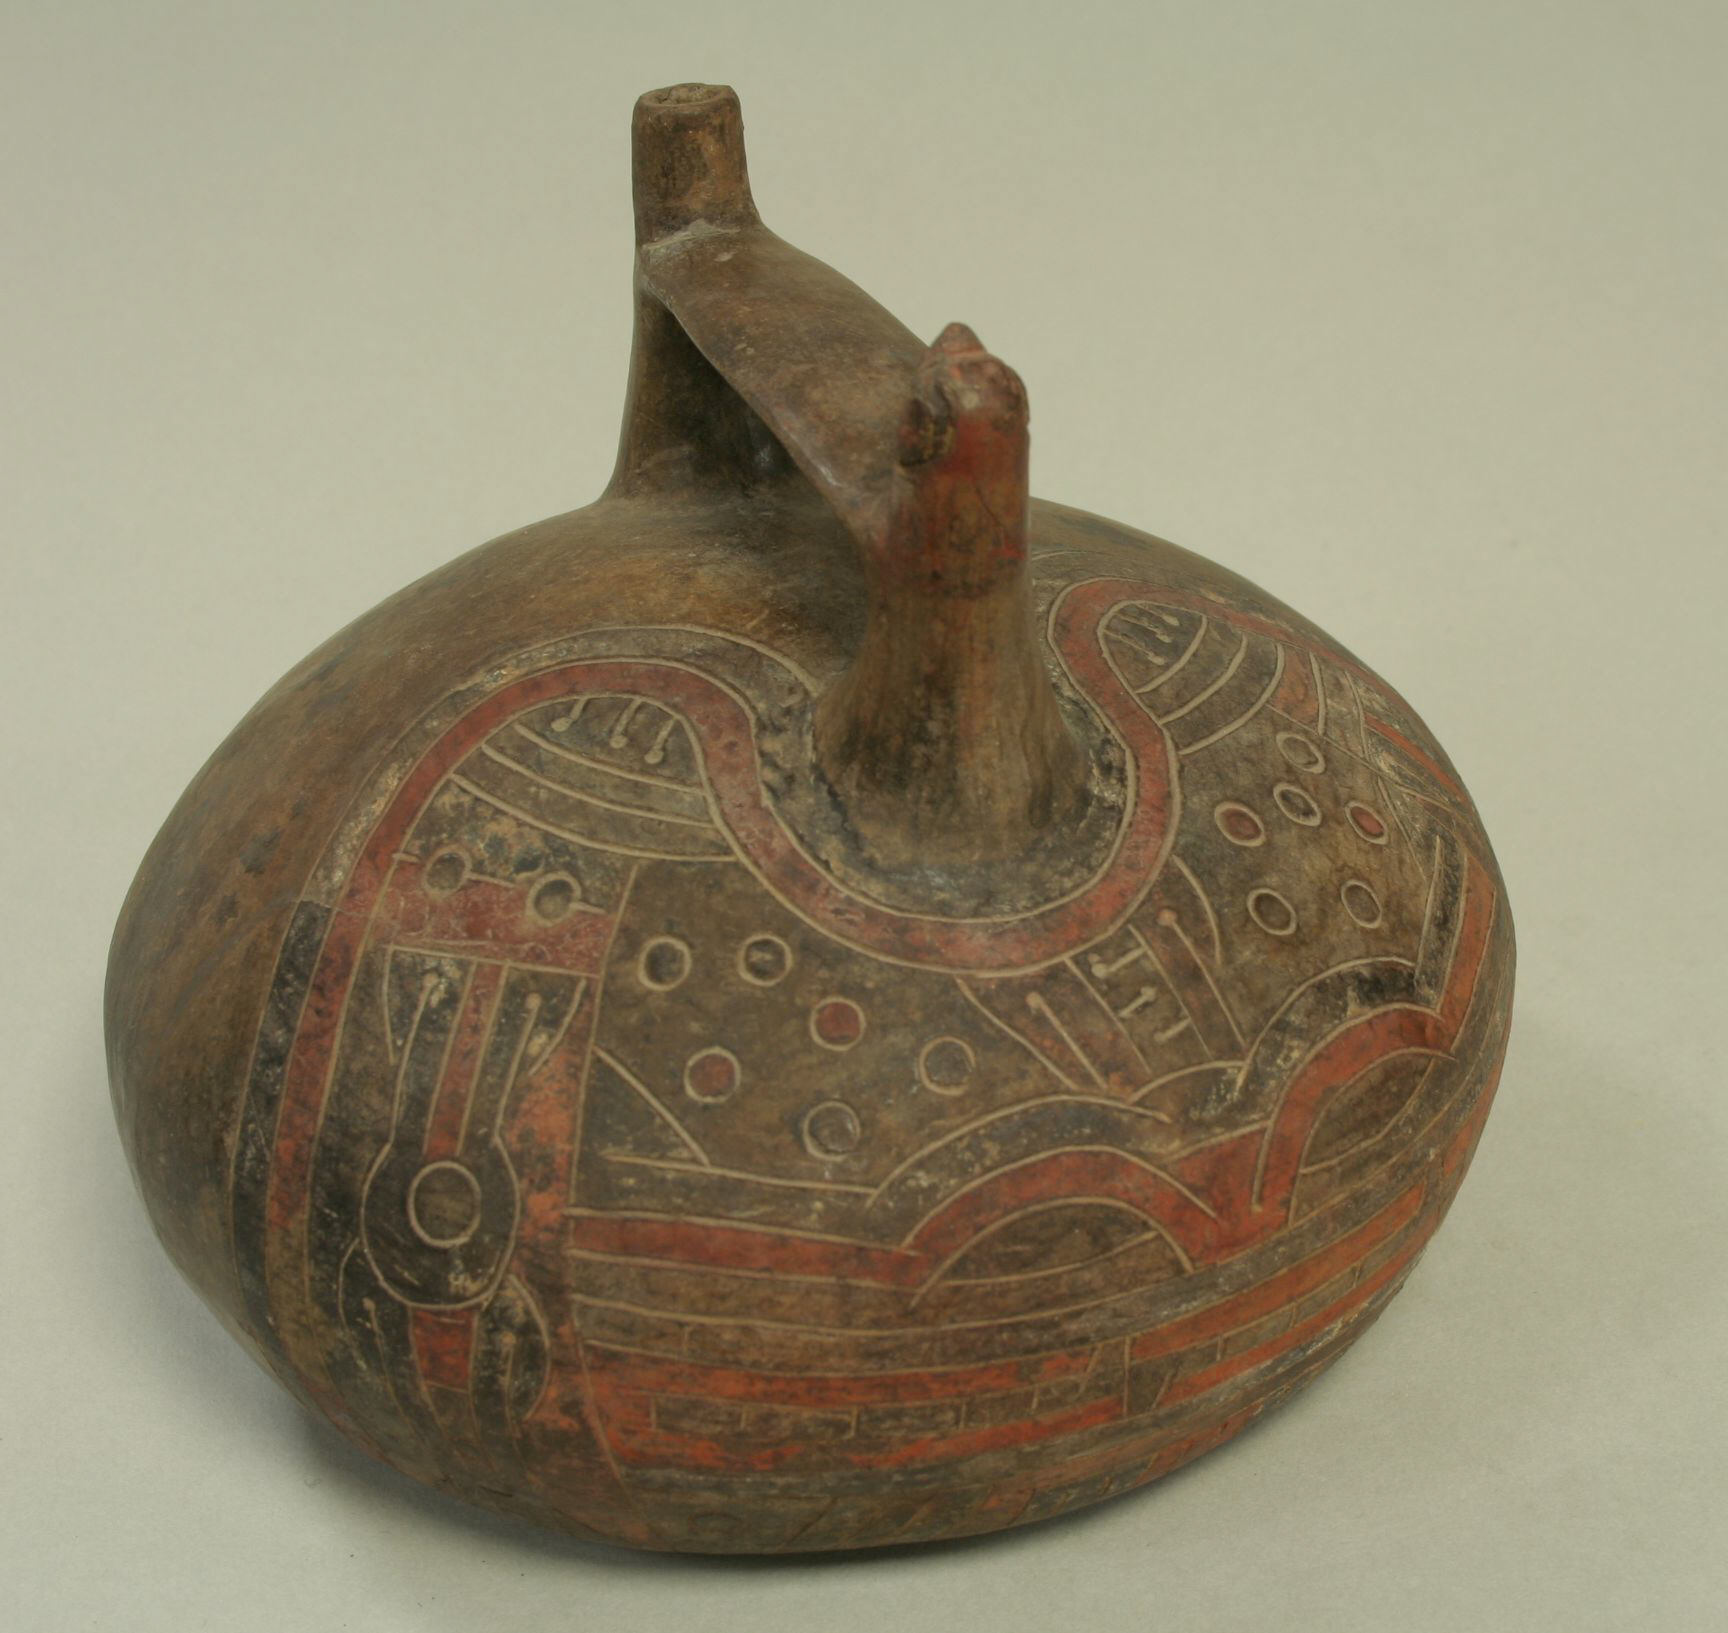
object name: bottle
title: Double Spout and Bridge Bottle with Bird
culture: paracas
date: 500-101 BCE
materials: ceramic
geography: peru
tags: birds